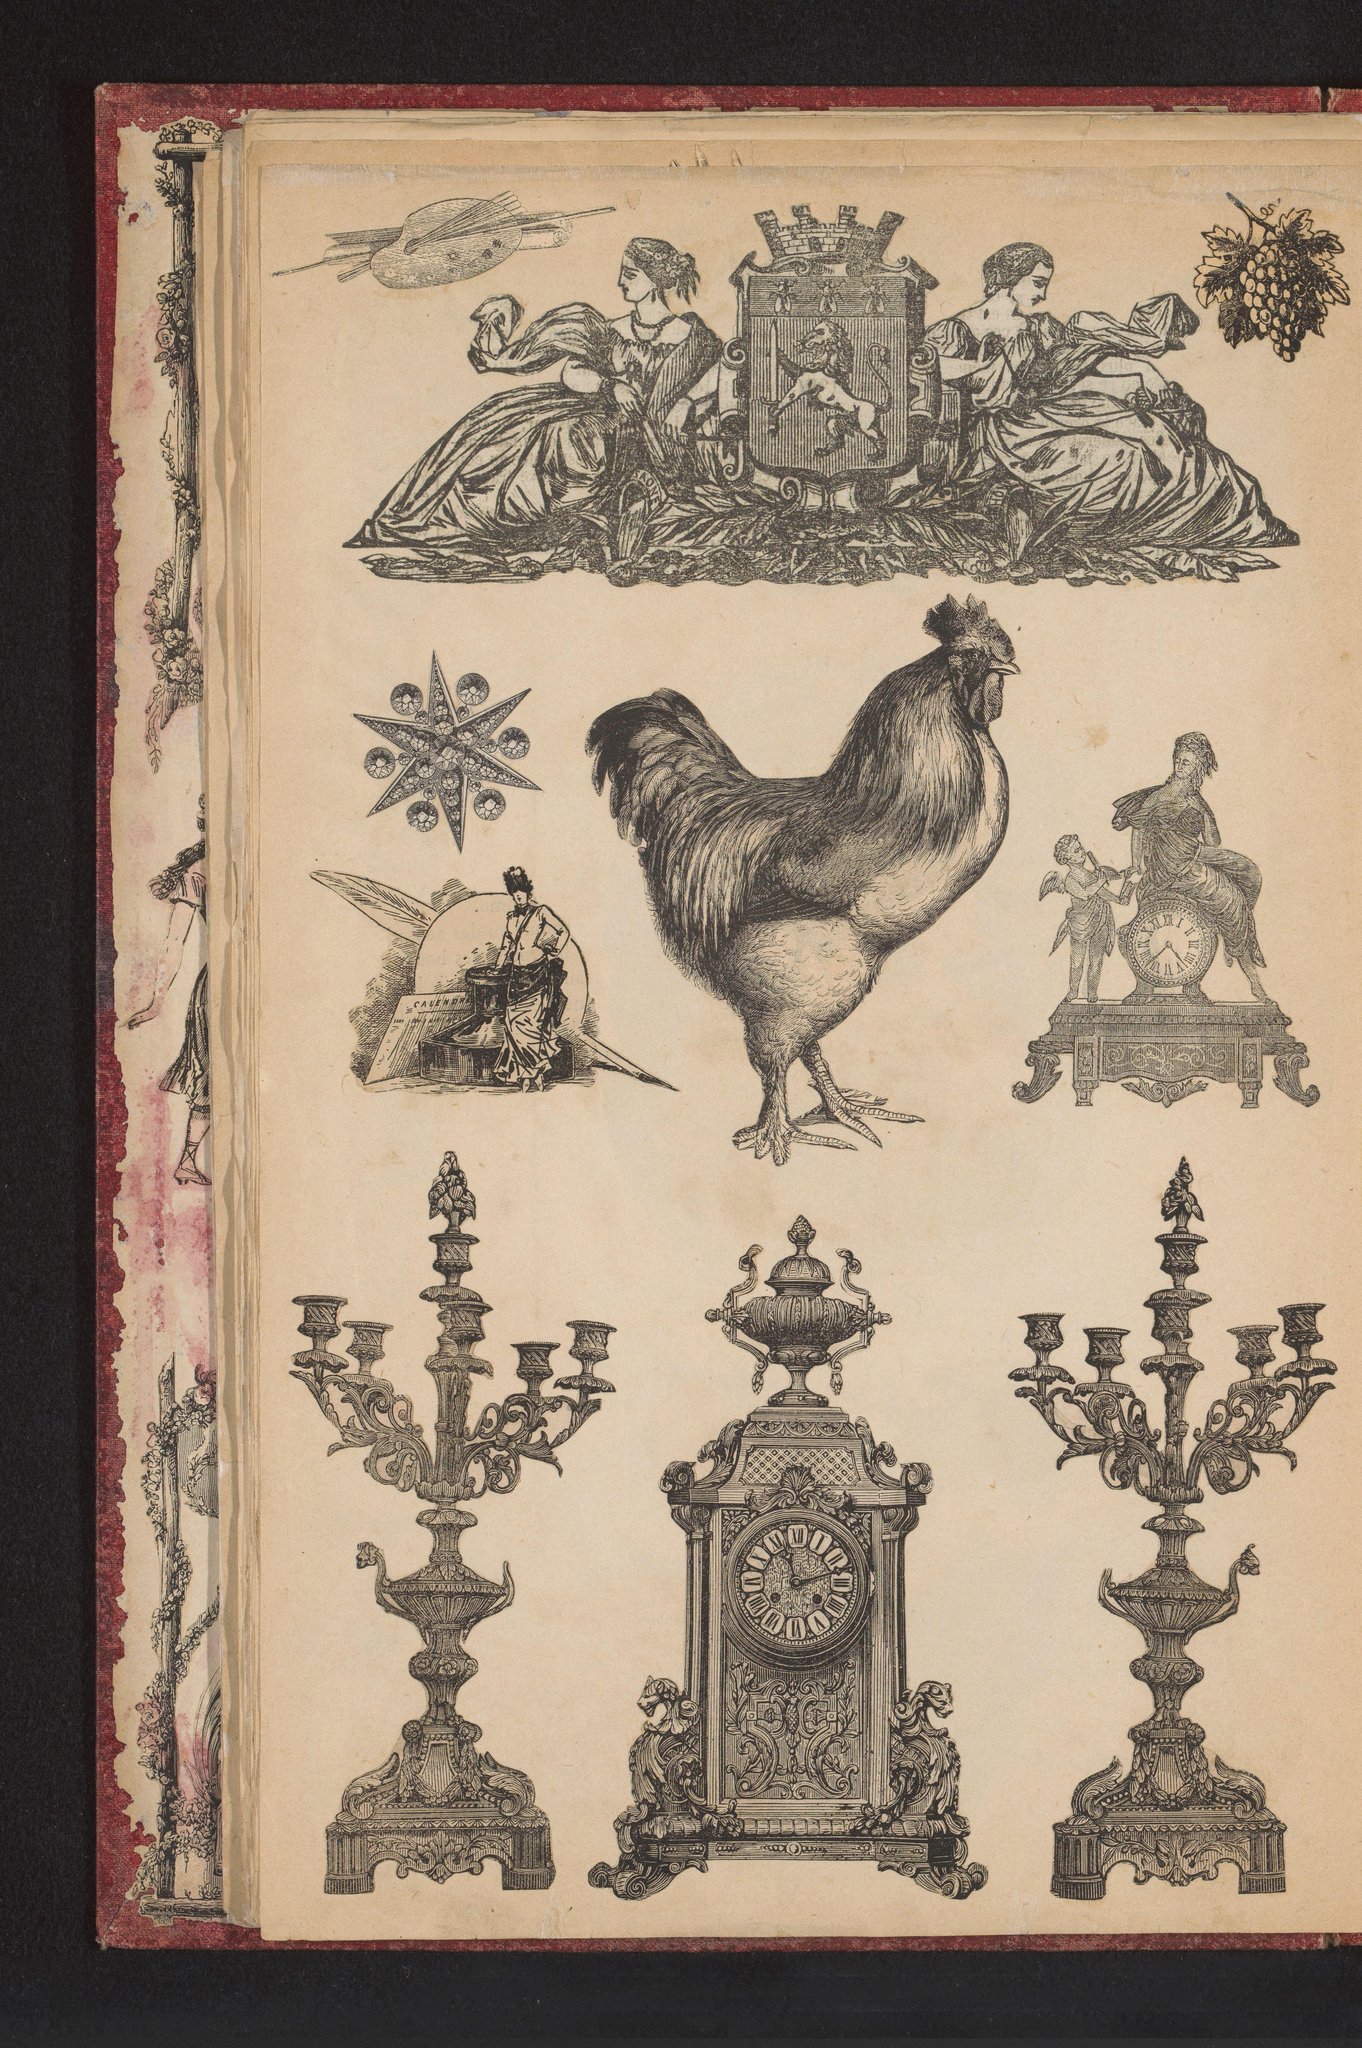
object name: print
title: Collage van uitgeknipte prenten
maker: Anonymous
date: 1870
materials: paper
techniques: engraving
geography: paris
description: Collage van uitgeknipte prenten. Onderdeel van een album met 32 bladen, aan beide zijden beplakt met uitgeknipte prenten, vermoedelijk afkomstig uit 19e-eeuwse tijdschiften.